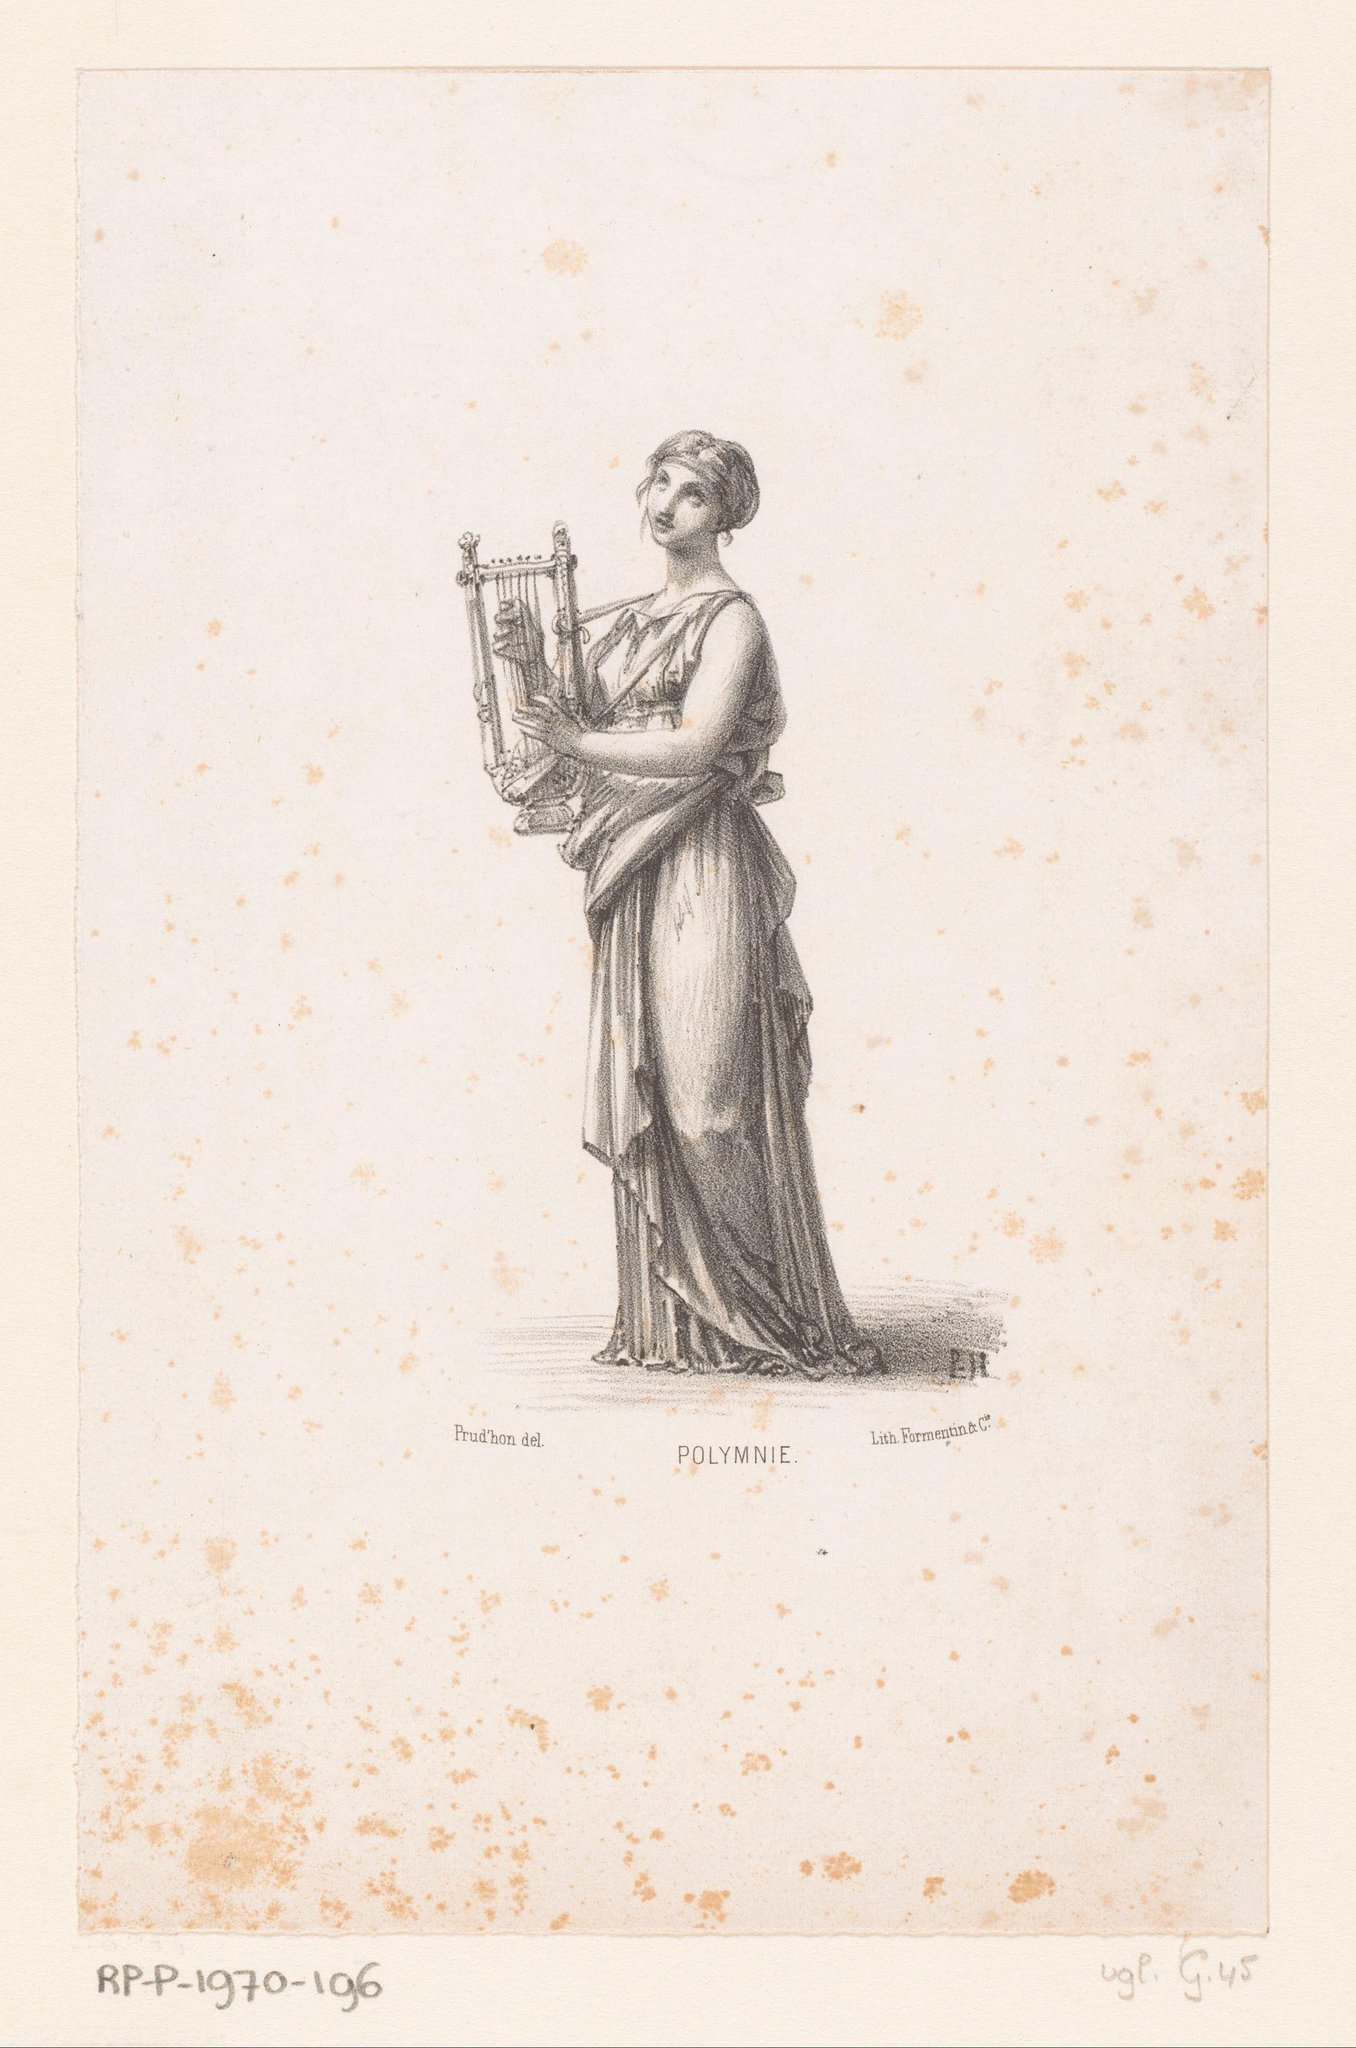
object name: print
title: Polymnie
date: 1824-1856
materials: paper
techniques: lithograph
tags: polyhymnia (one of the muses); 'polinnia' (ripa)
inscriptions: collector's mark: Lugt 2228a, collector's mark: Lugt 2760